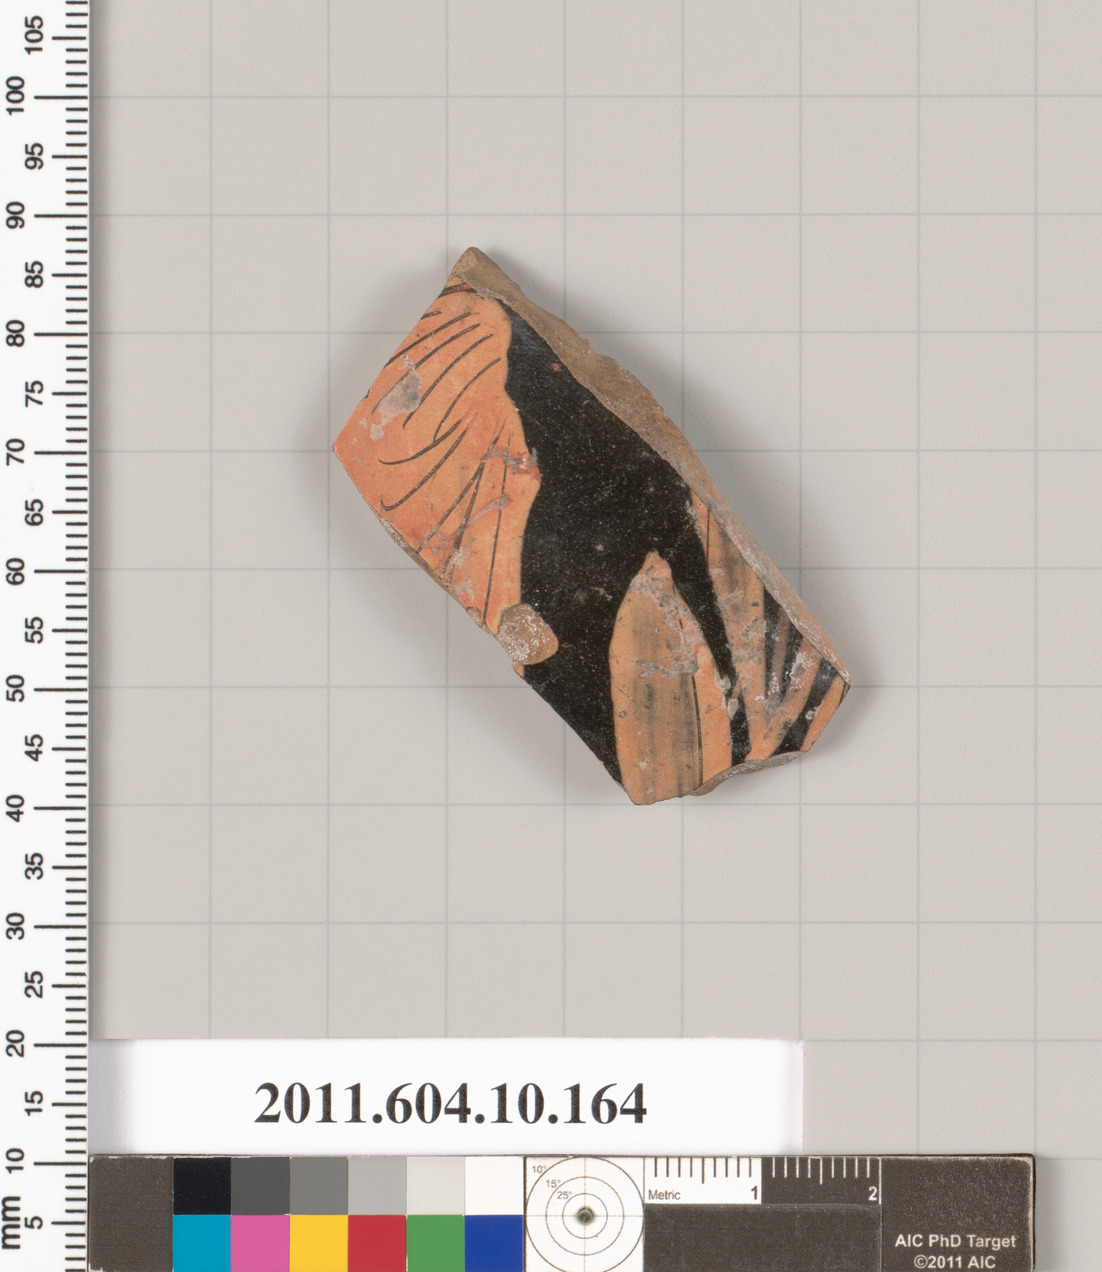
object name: skyphos fragment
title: Terracotta fragment of a skyphos (deep drinking cup)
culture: etruscan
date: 434-368 BCE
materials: terracotta